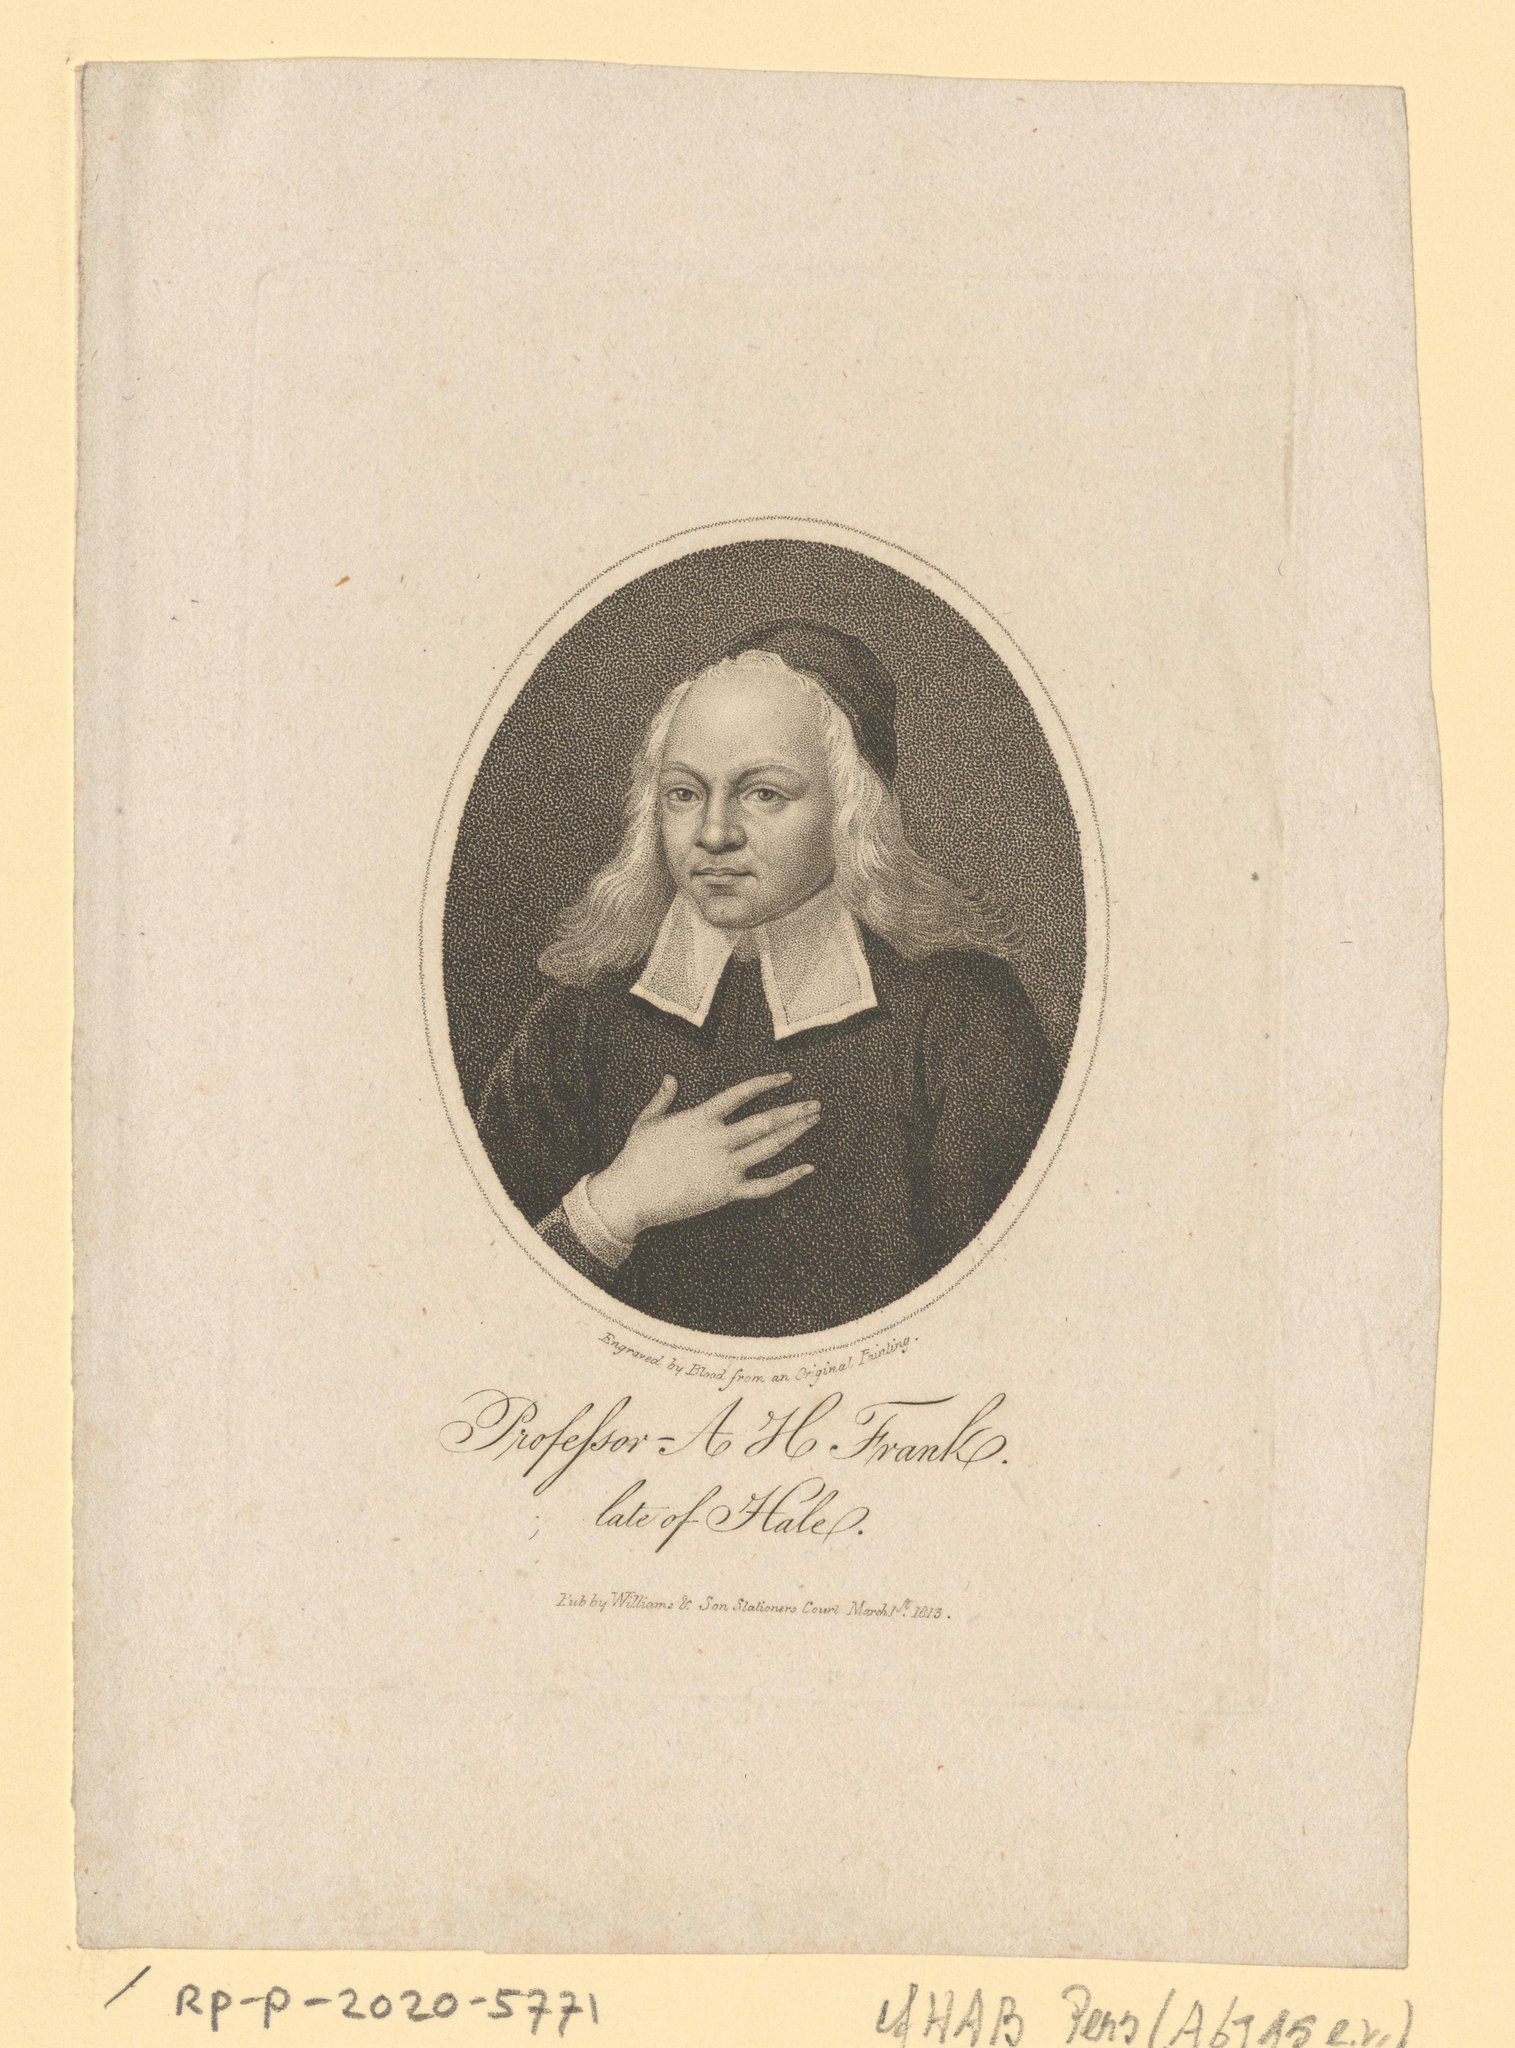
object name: print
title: Portret van August Hermann Francke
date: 1803-1813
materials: paper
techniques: engraving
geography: england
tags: theologian, historical persons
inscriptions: date